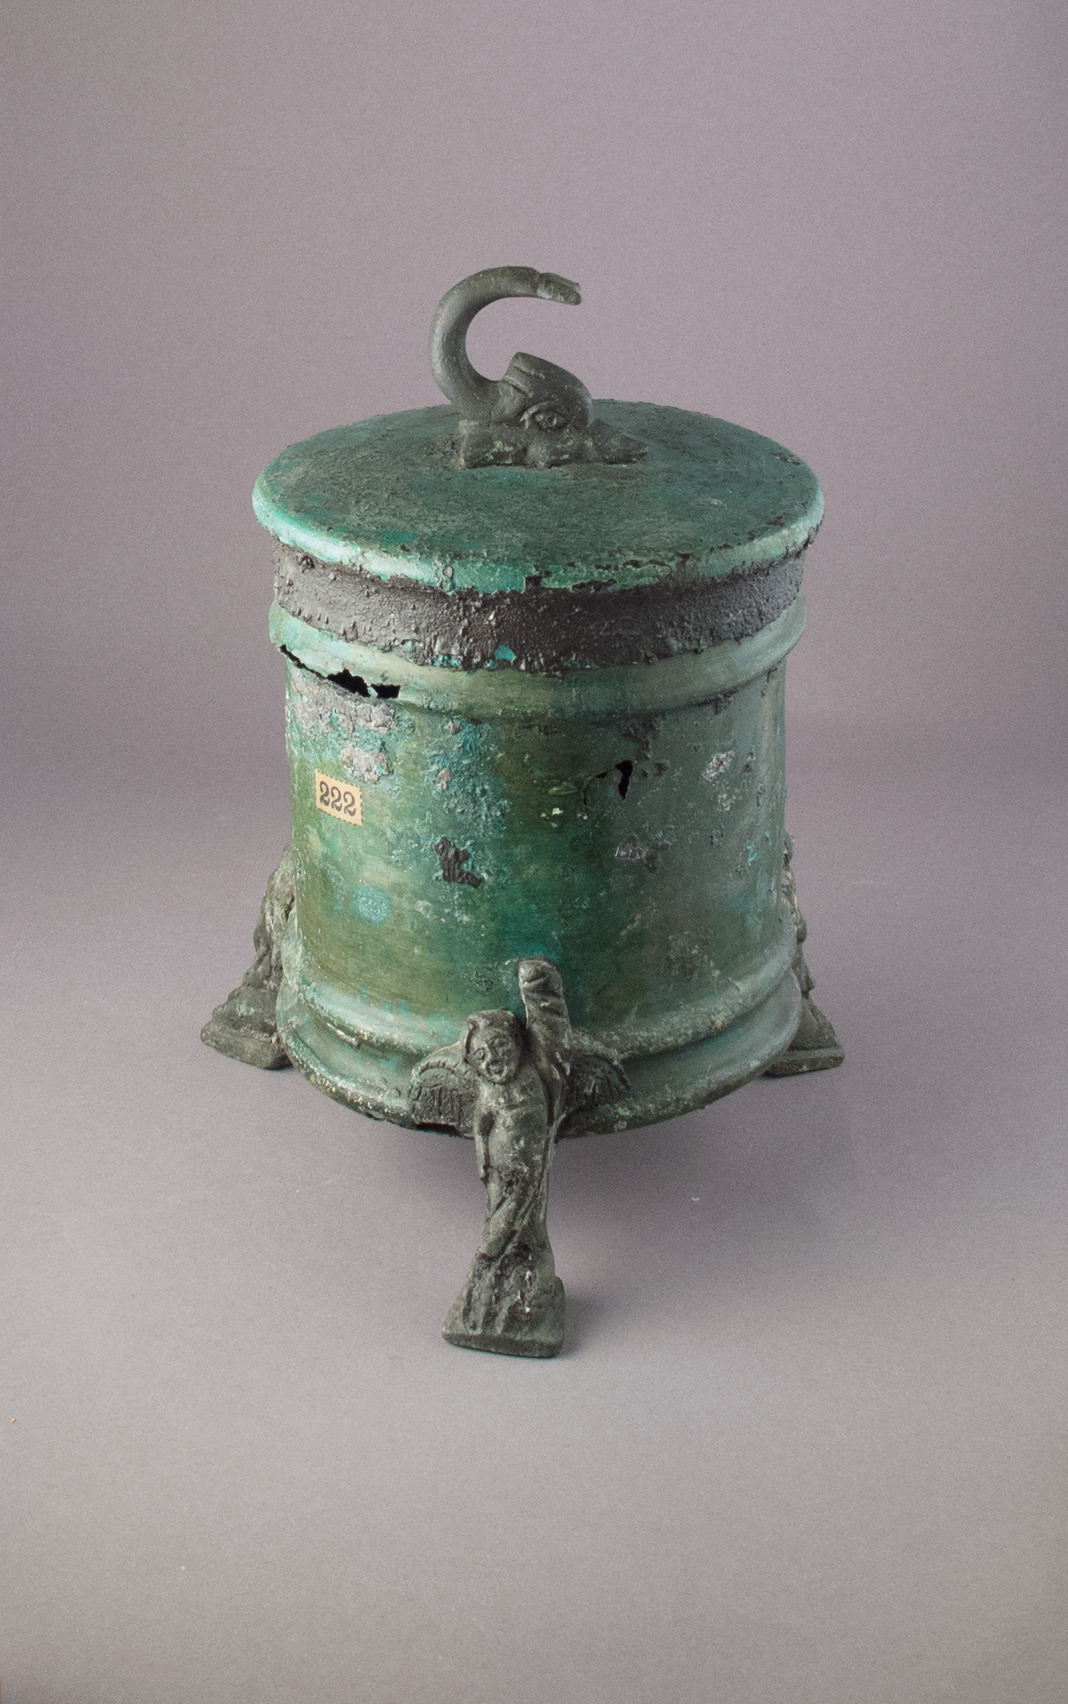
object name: cista with lid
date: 7000 BCE-330 CE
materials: bronze